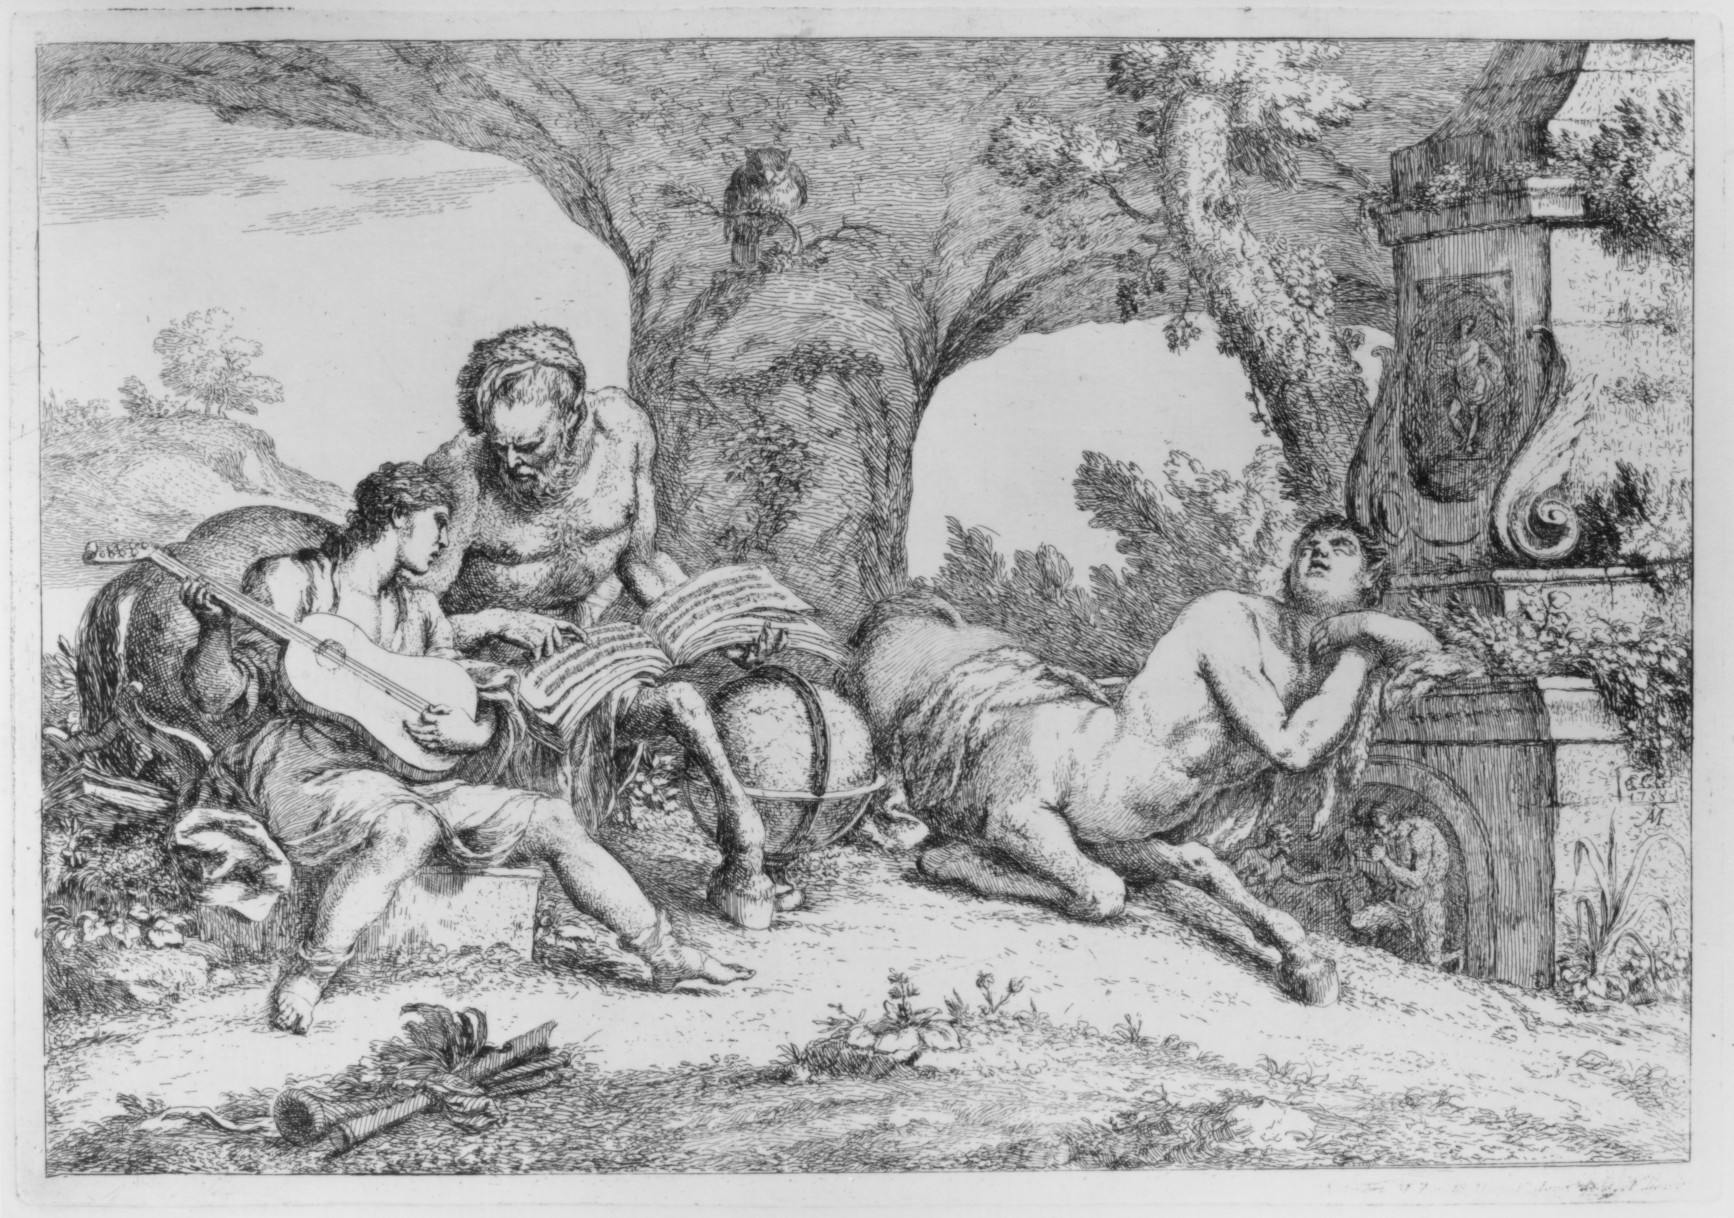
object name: book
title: Varii Capricci, e Paesi inventati, e disegnati dal celebre Gio. Benedetto Castiglione ... tratti dal raccolta Zanettiana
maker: gaetano gherardo zompini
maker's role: etcher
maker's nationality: italian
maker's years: 1700-1778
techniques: etching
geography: italy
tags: women,guitars